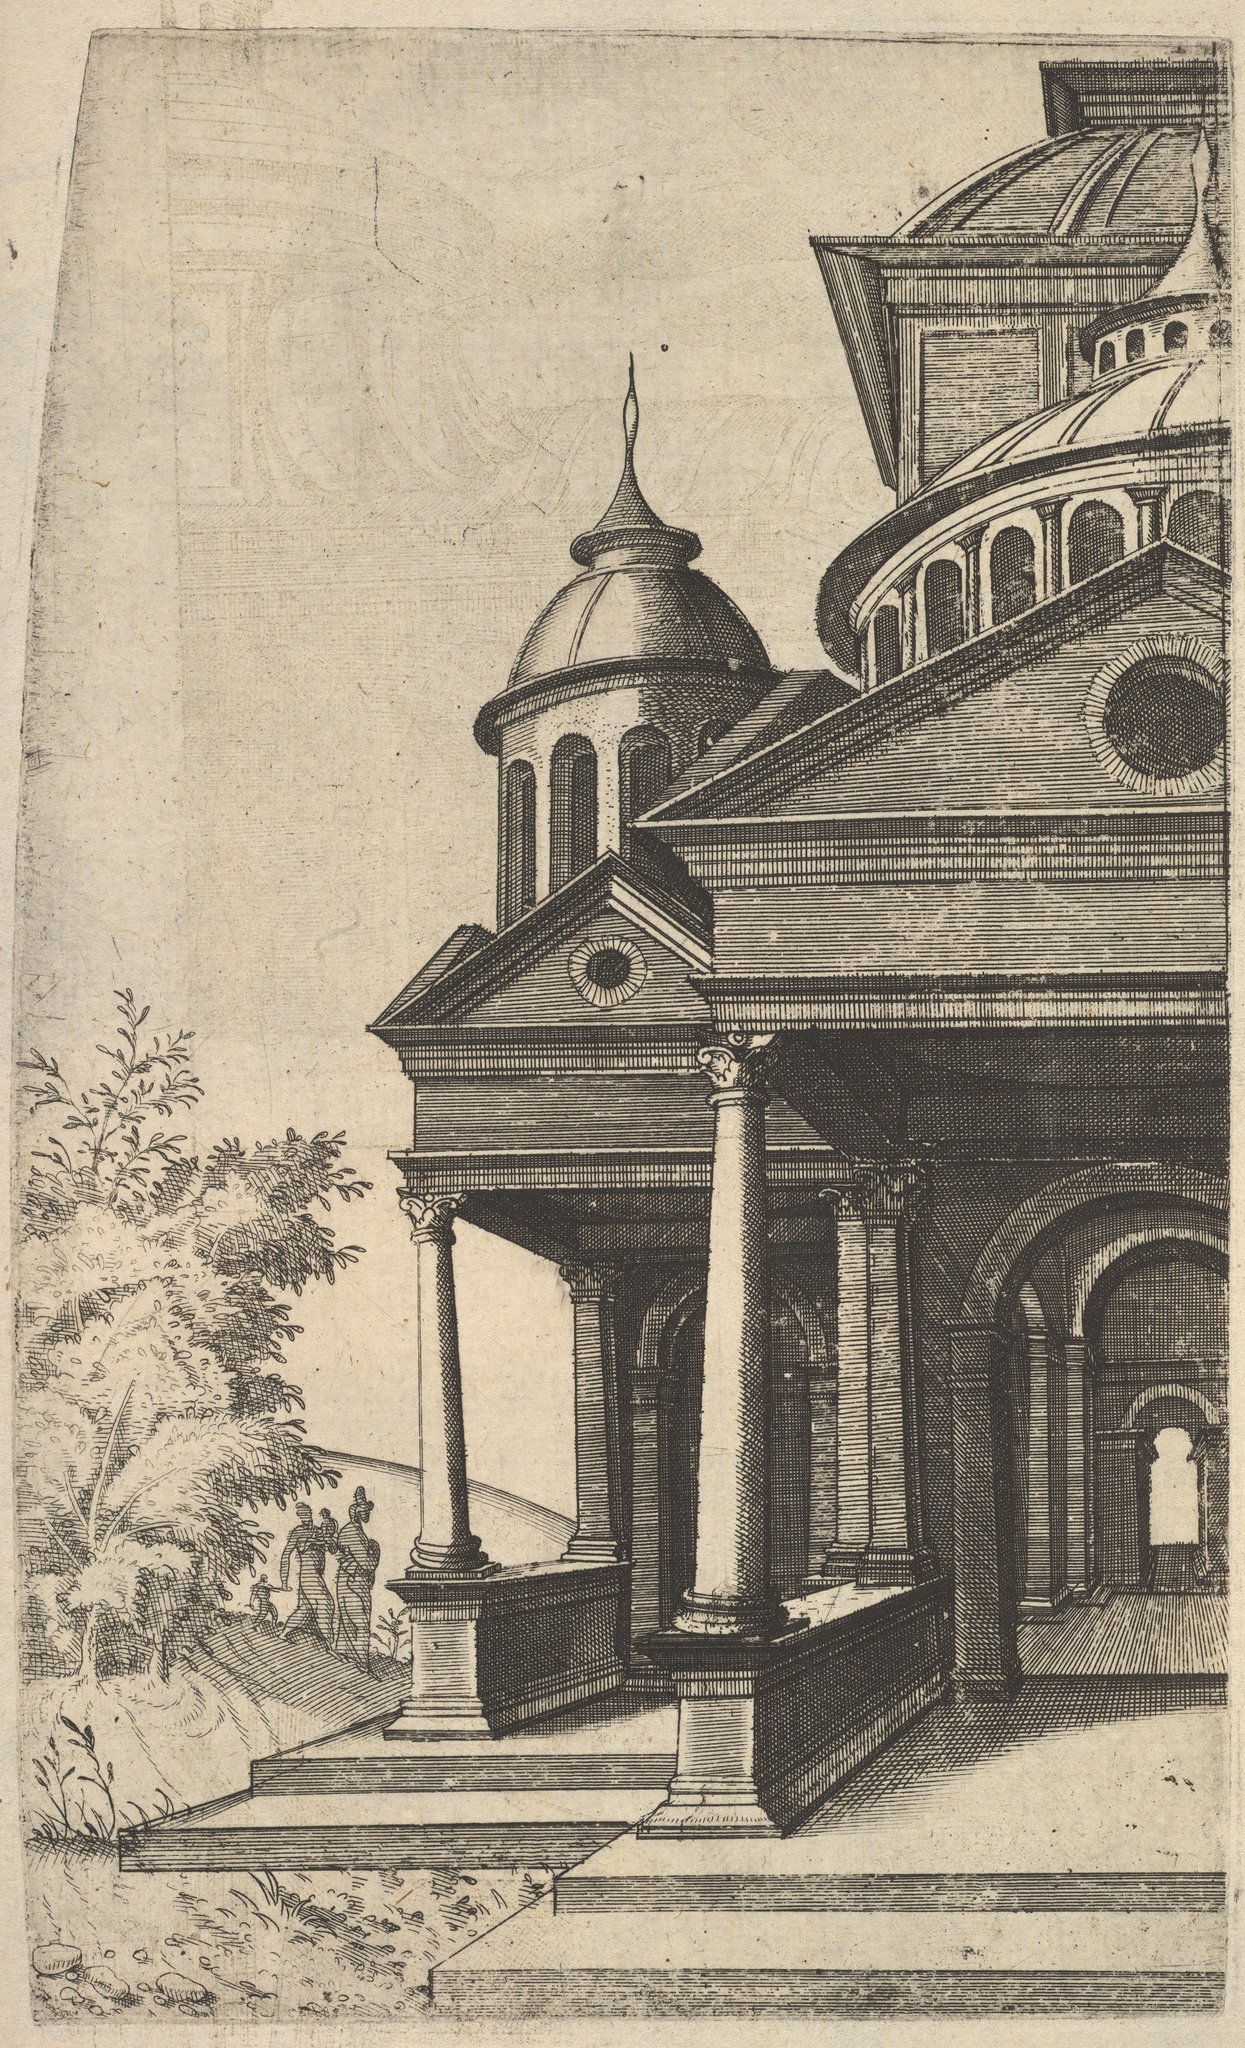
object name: book print ornament architecture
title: Half of Building [Templum Saturni] from the series 'Ruinarum variarum fabricarum delineationes pictoribus caeterisque id genus artificibus multum utiles'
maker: lambert suavius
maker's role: artist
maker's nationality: netherlandish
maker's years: 1510-1576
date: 1554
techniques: etching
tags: architecture